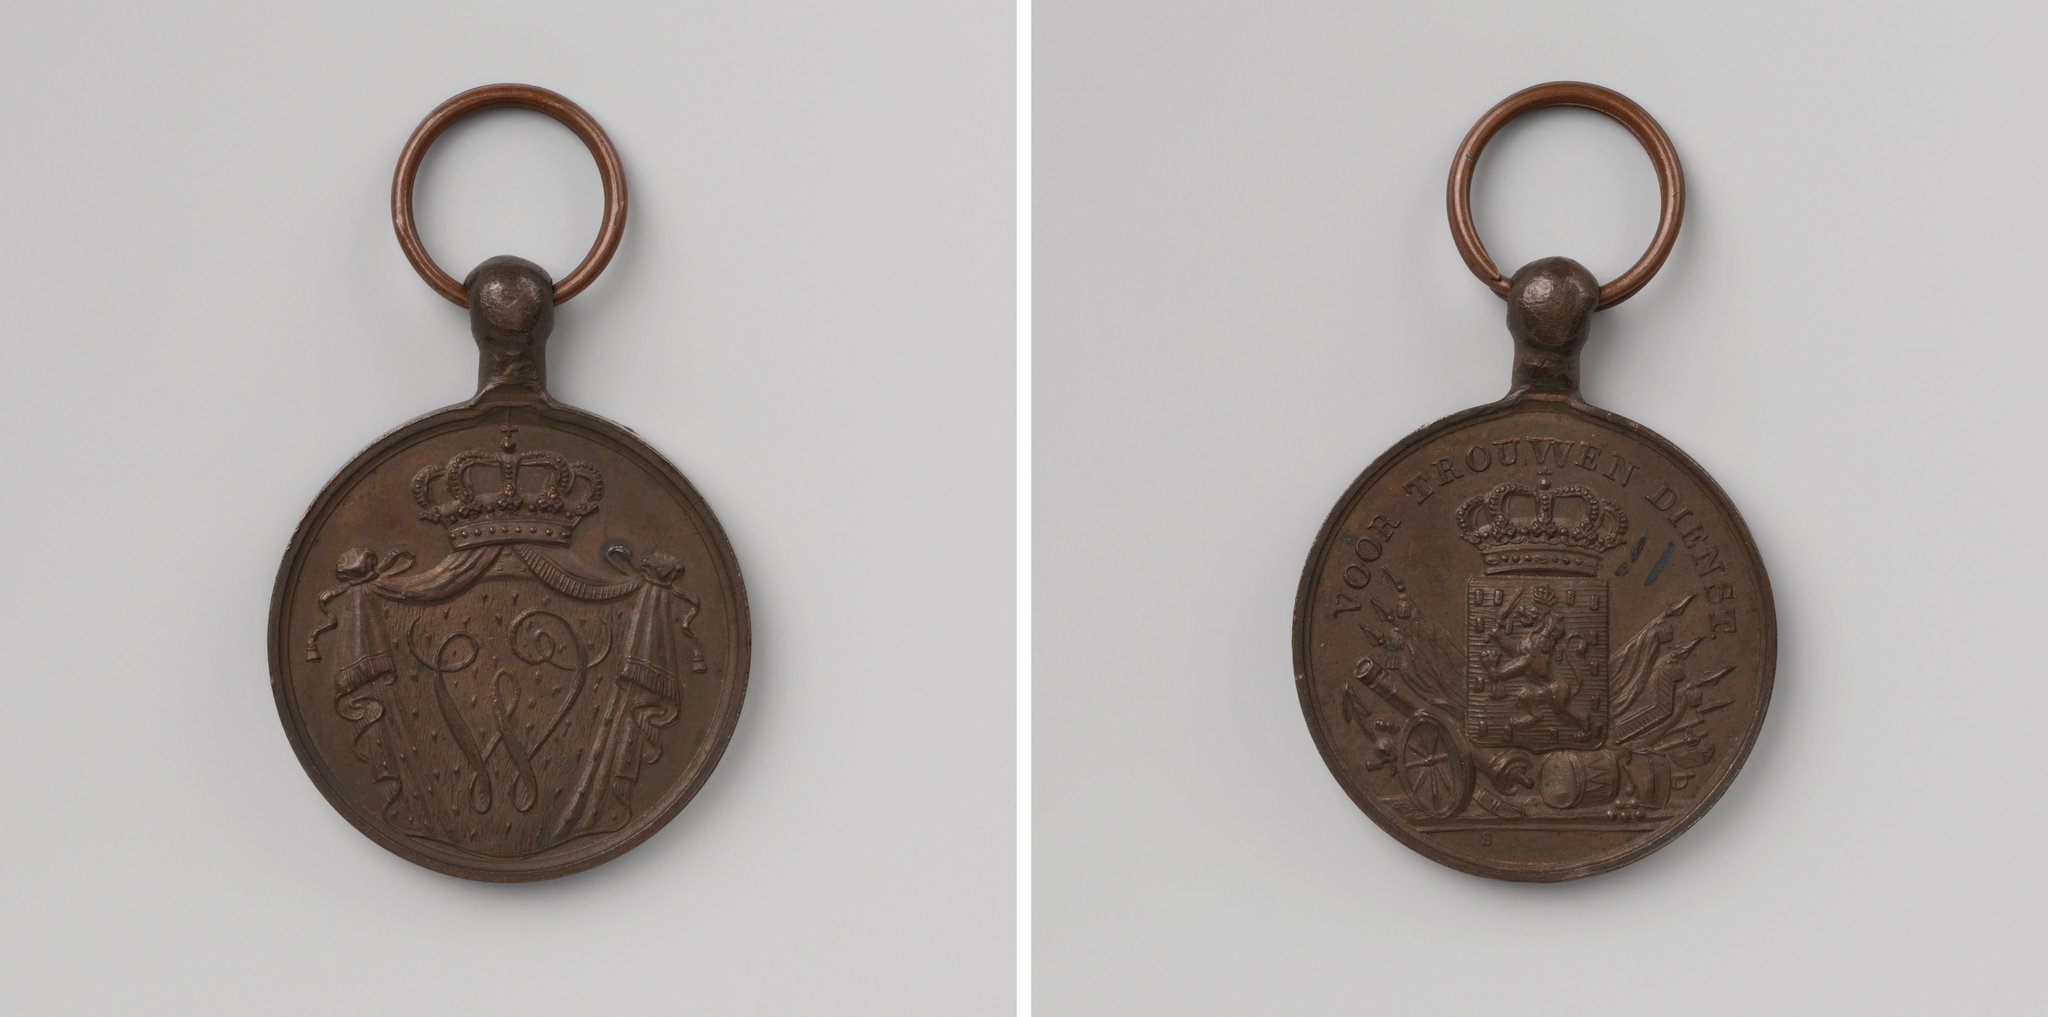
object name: insignia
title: Trouwen dienst bij de landmacht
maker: jean henri simon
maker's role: medailleur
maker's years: 1752-1834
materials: bronze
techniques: striking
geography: brussels